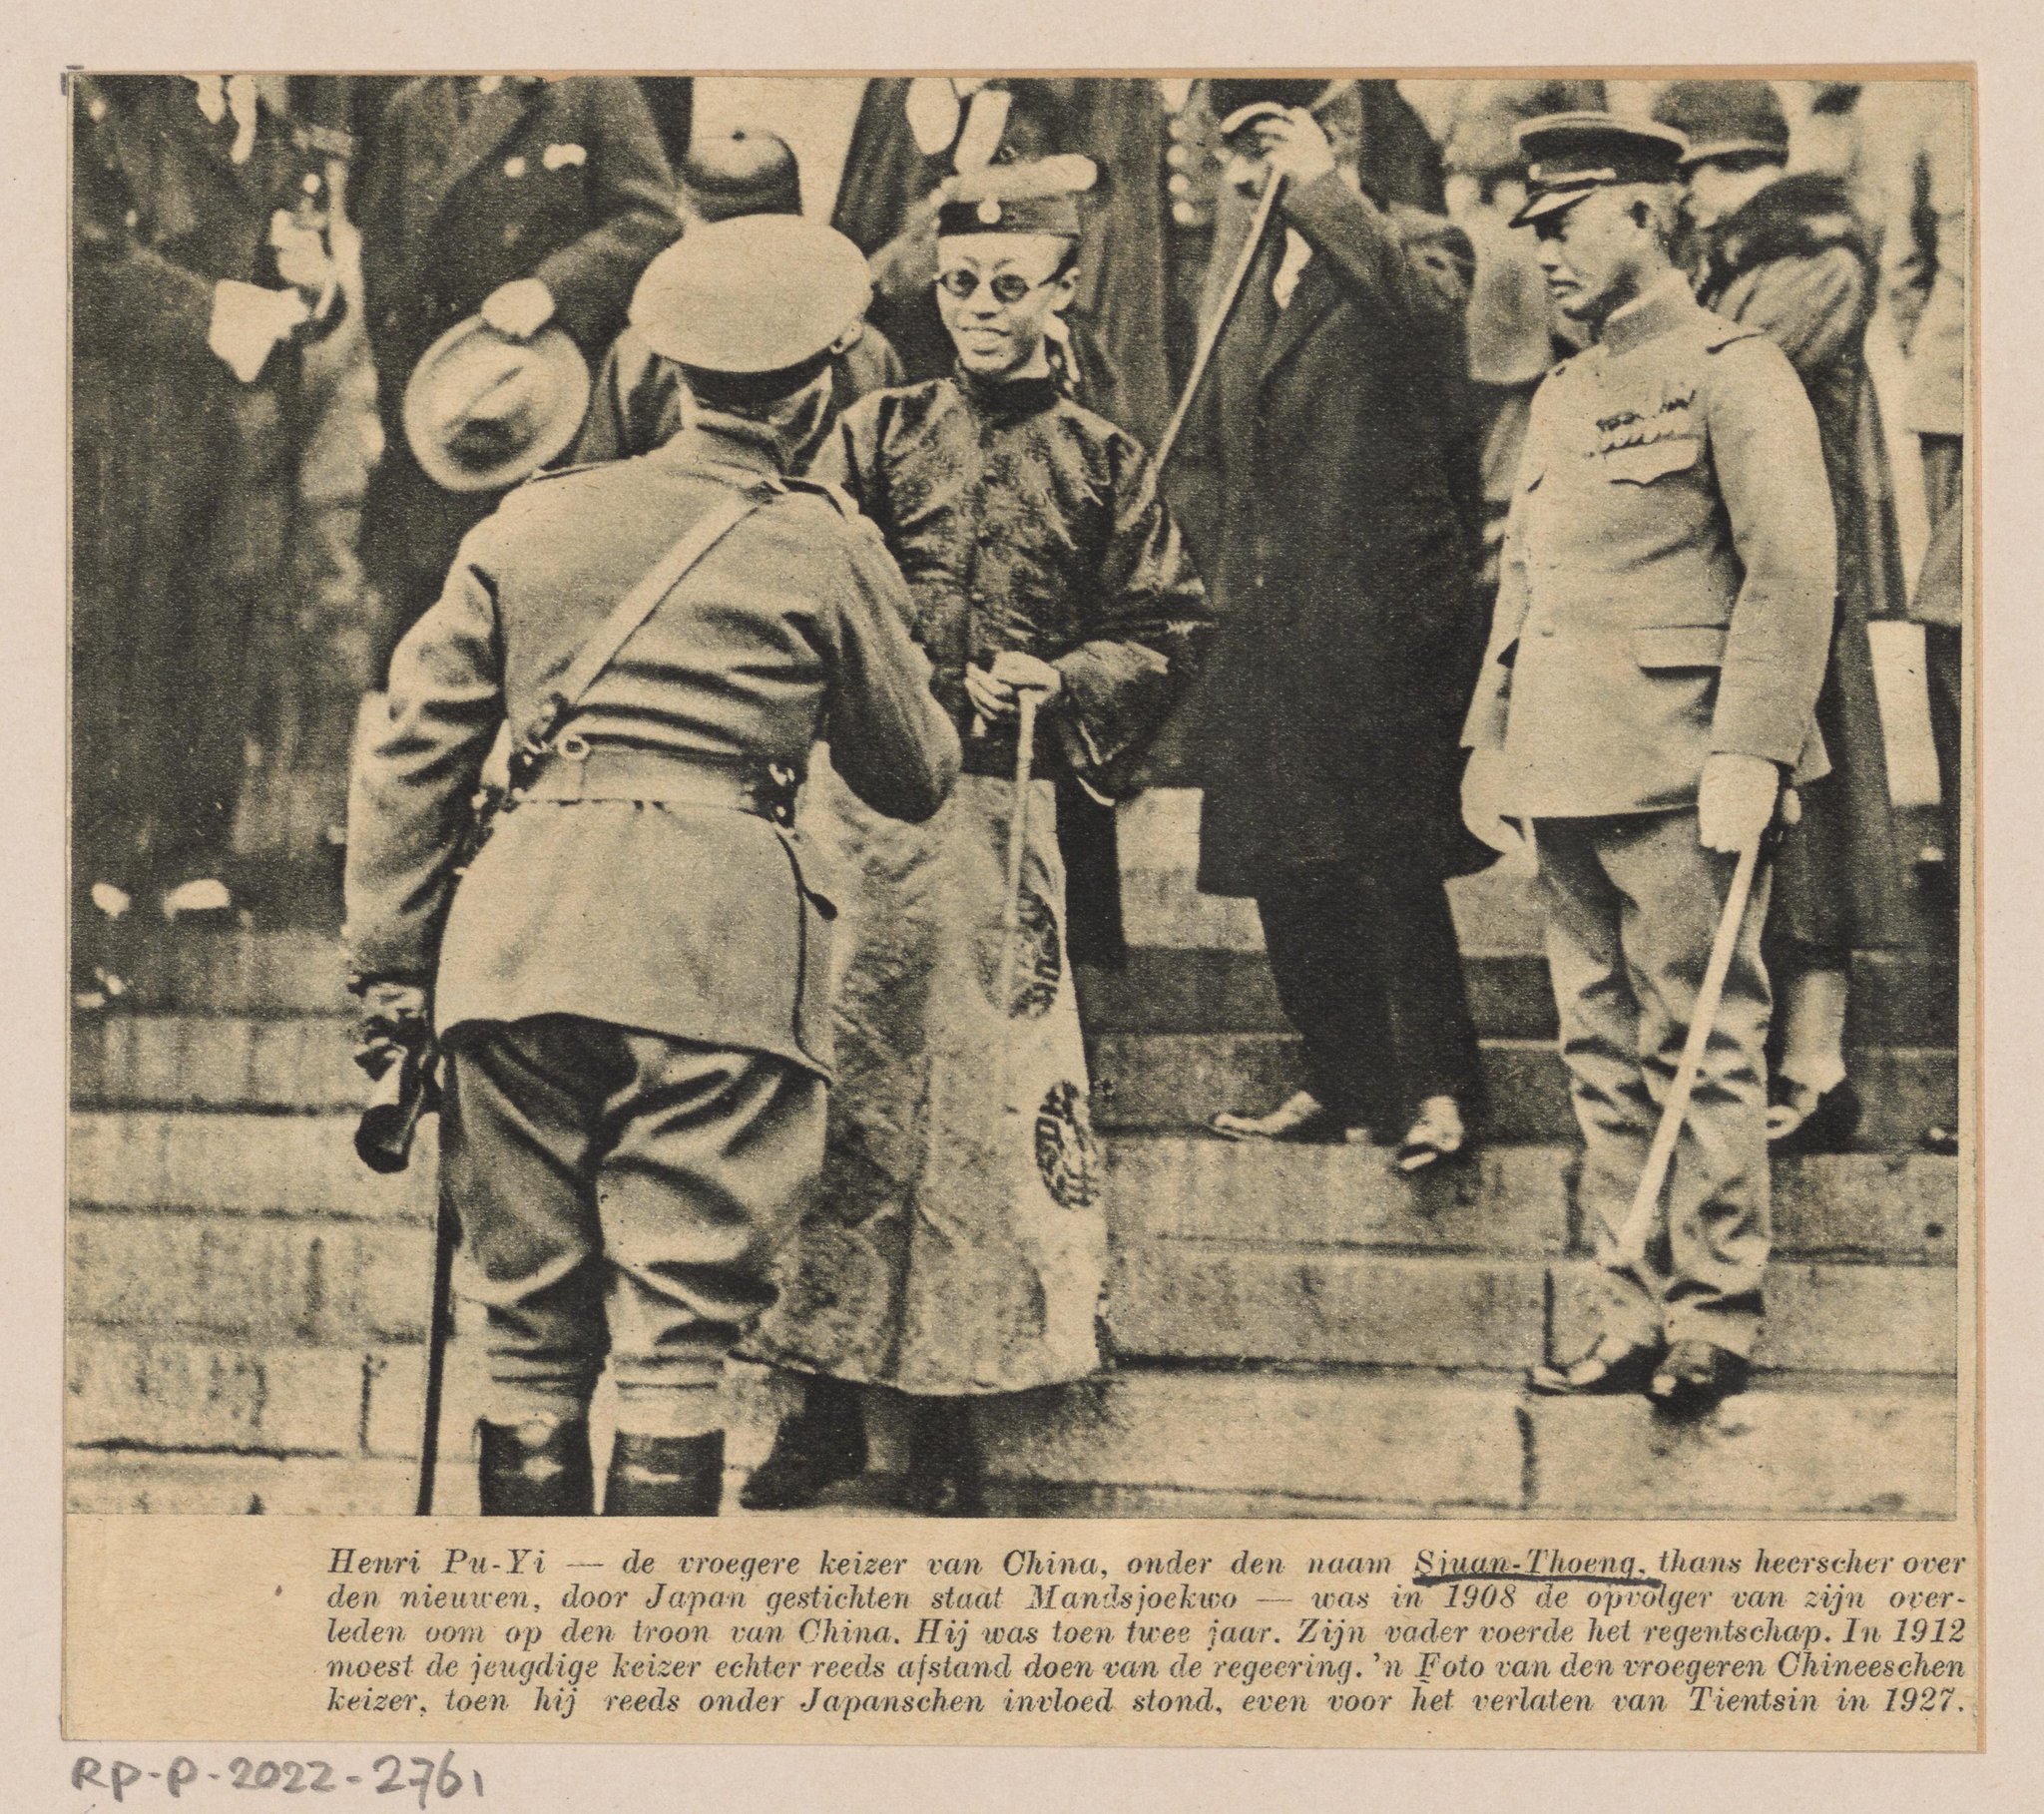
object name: photomechanical print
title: Portret van Puyi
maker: Anonymous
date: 1927-1930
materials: paper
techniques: photograph, letterpress printing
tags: historical persons, emperor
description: Fotomechanische afdruk uit een onbekende publicatie.